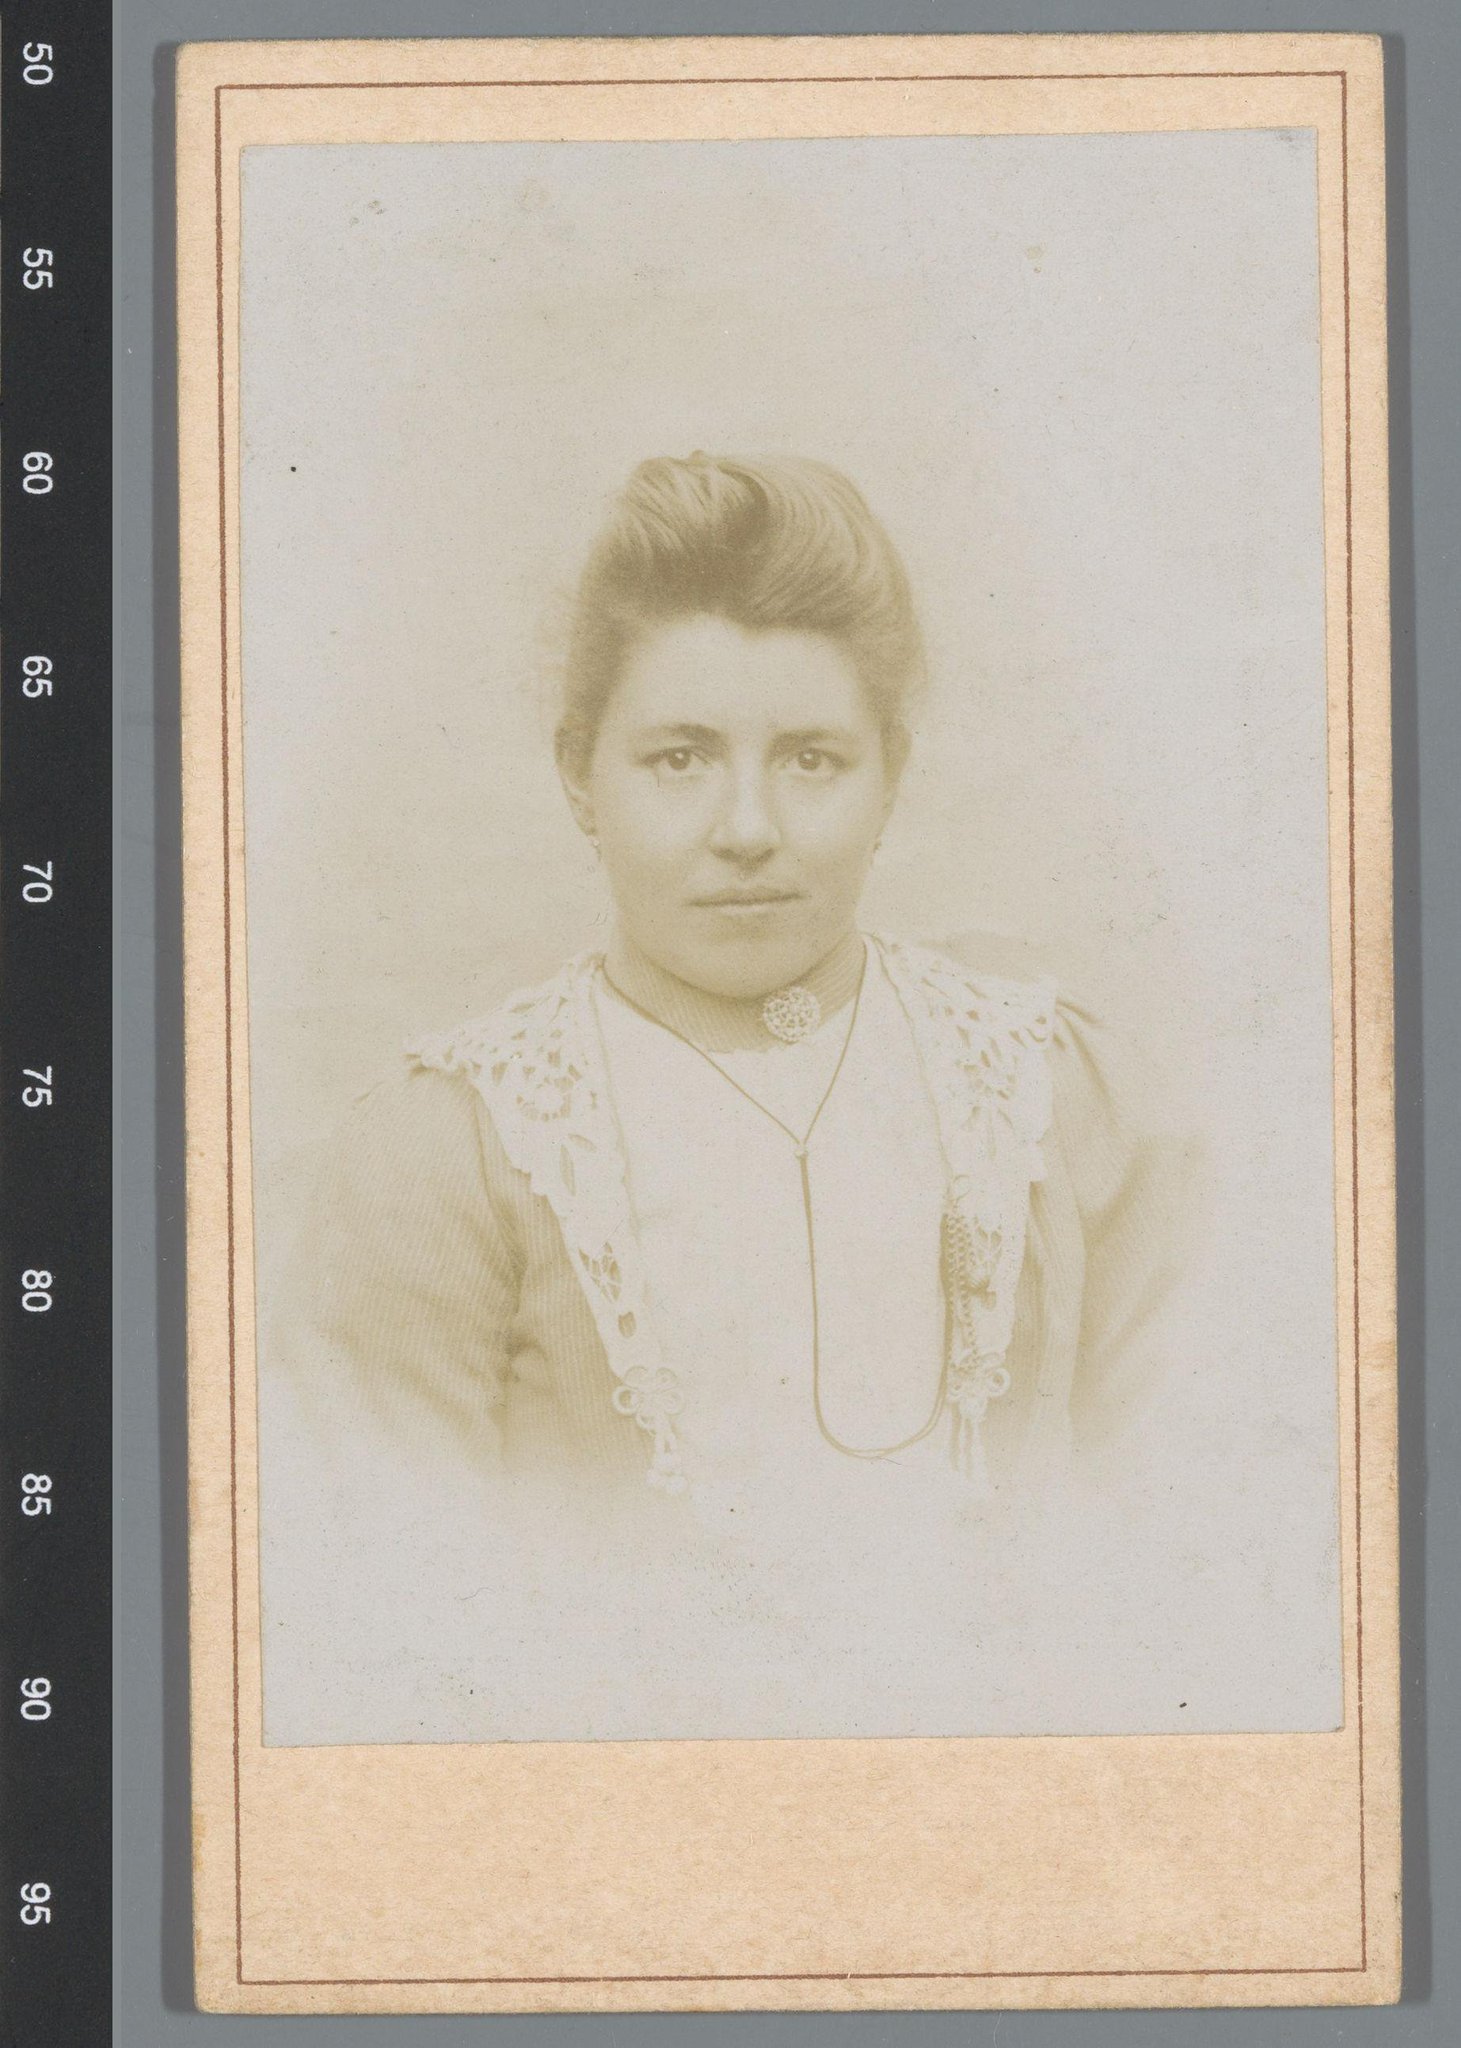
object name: carte de visite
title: Portret van een onbekende vrouw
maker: m.j.a. van leeuwen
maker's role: fotograaf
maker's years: 1879-1953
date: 1903-1906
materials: cardboard, photographic support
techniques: collodion silver print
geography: the hague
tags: historical persons - bb - woman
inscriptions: stamp: ‘M. J. A. VAN LEEUWEN. PHOTOGRAPHE/ BLEYENBURG No. 42 A./ DEN HAAG’